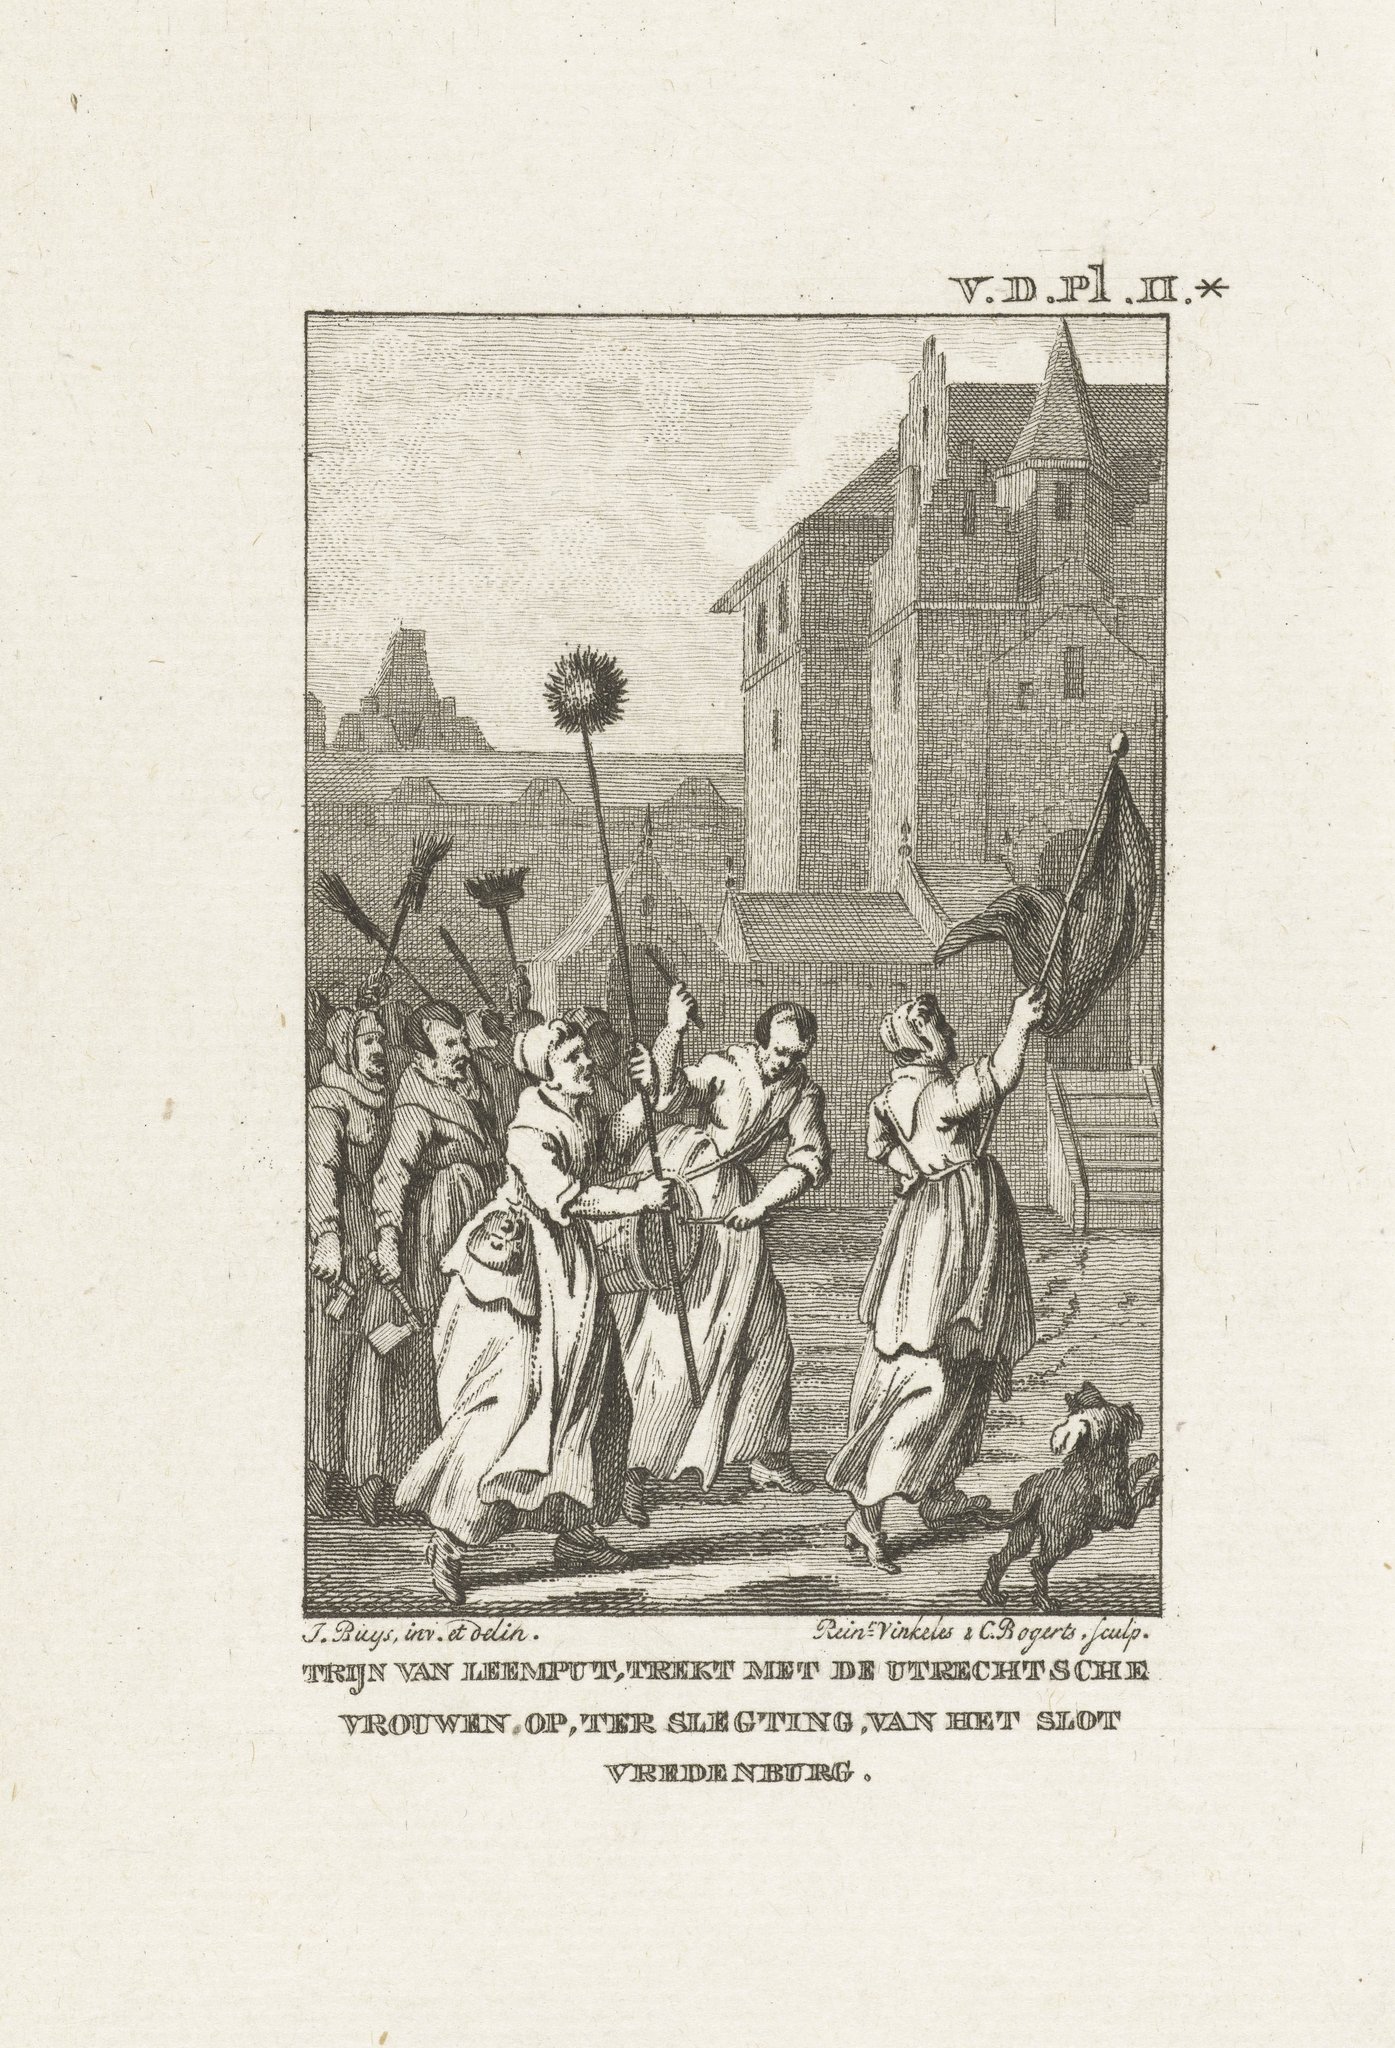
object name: history print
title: Trijn van Leemput, trekt met de Utrechtsche vrouwen, op ter slegting, van het slot Vredenburg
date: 1780-1795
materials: paper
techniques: etching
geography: netherlands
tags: utrecht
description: Trijn van Leemput trekt met een groepje vrouwen gewapend met hamers en pikhouwelen op naar het kasteel Vredenburg, 2 mei 1577. Voorop loopt een vrouw met een vlag, daarachter een vrouw die op een trom slaat en een vrouw met een ragebol.